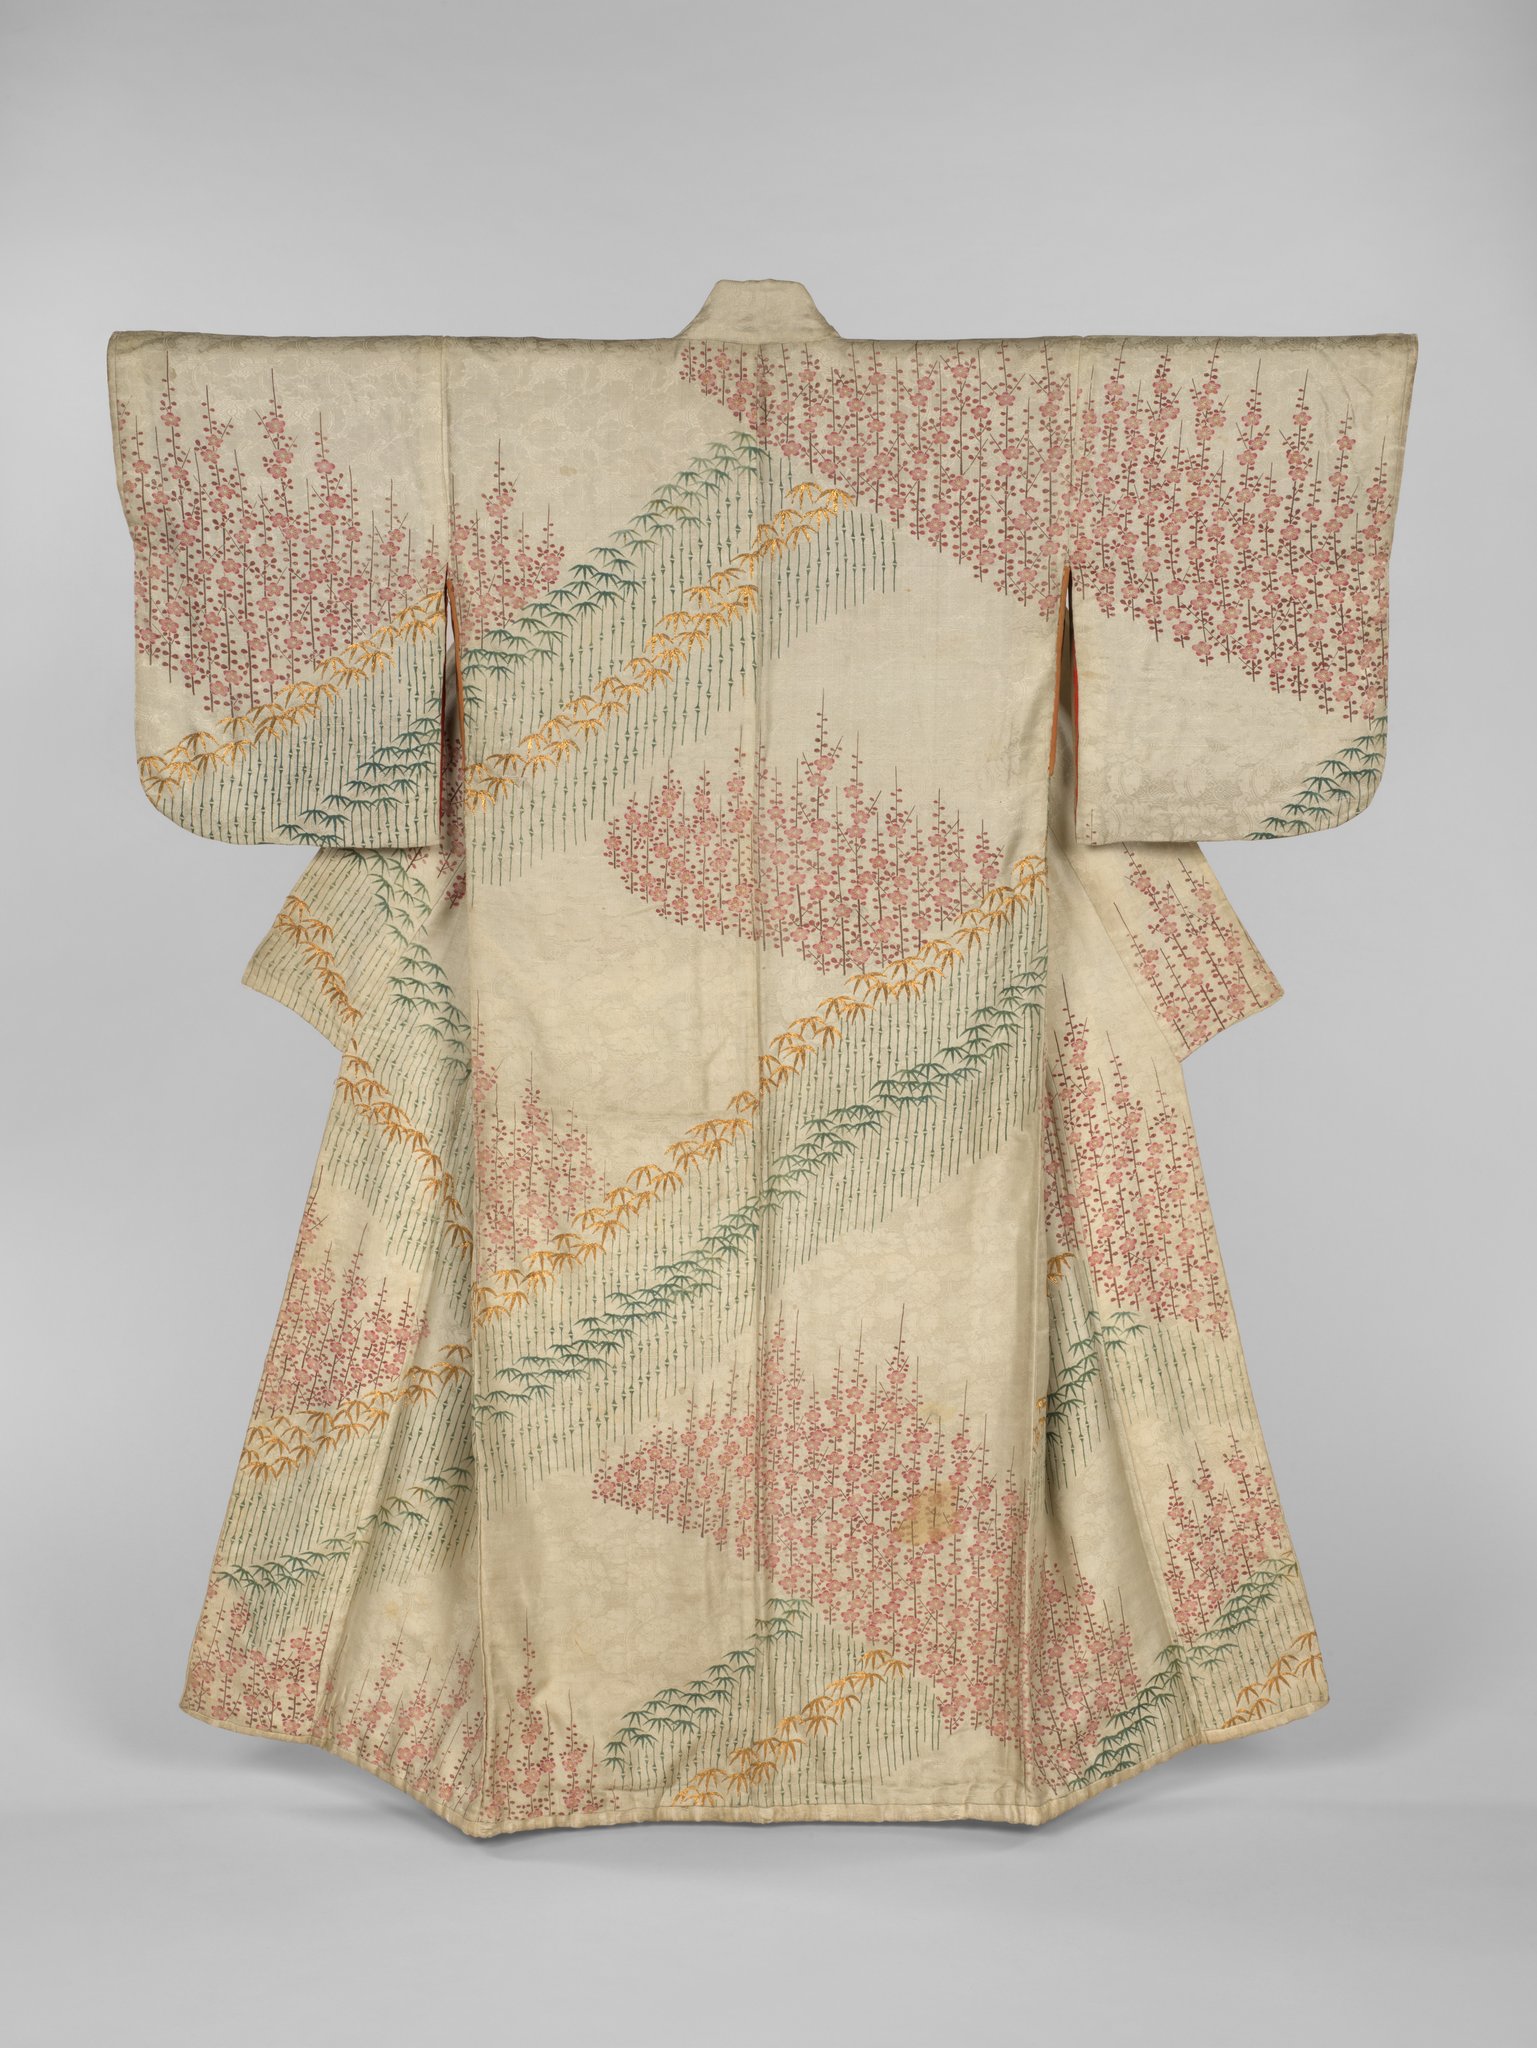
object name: kosode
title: Robe (Kosode) with Bamboo and Plum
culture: japanese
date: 1751-1800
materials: gold thread, paste, silk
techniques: resist, satin weave